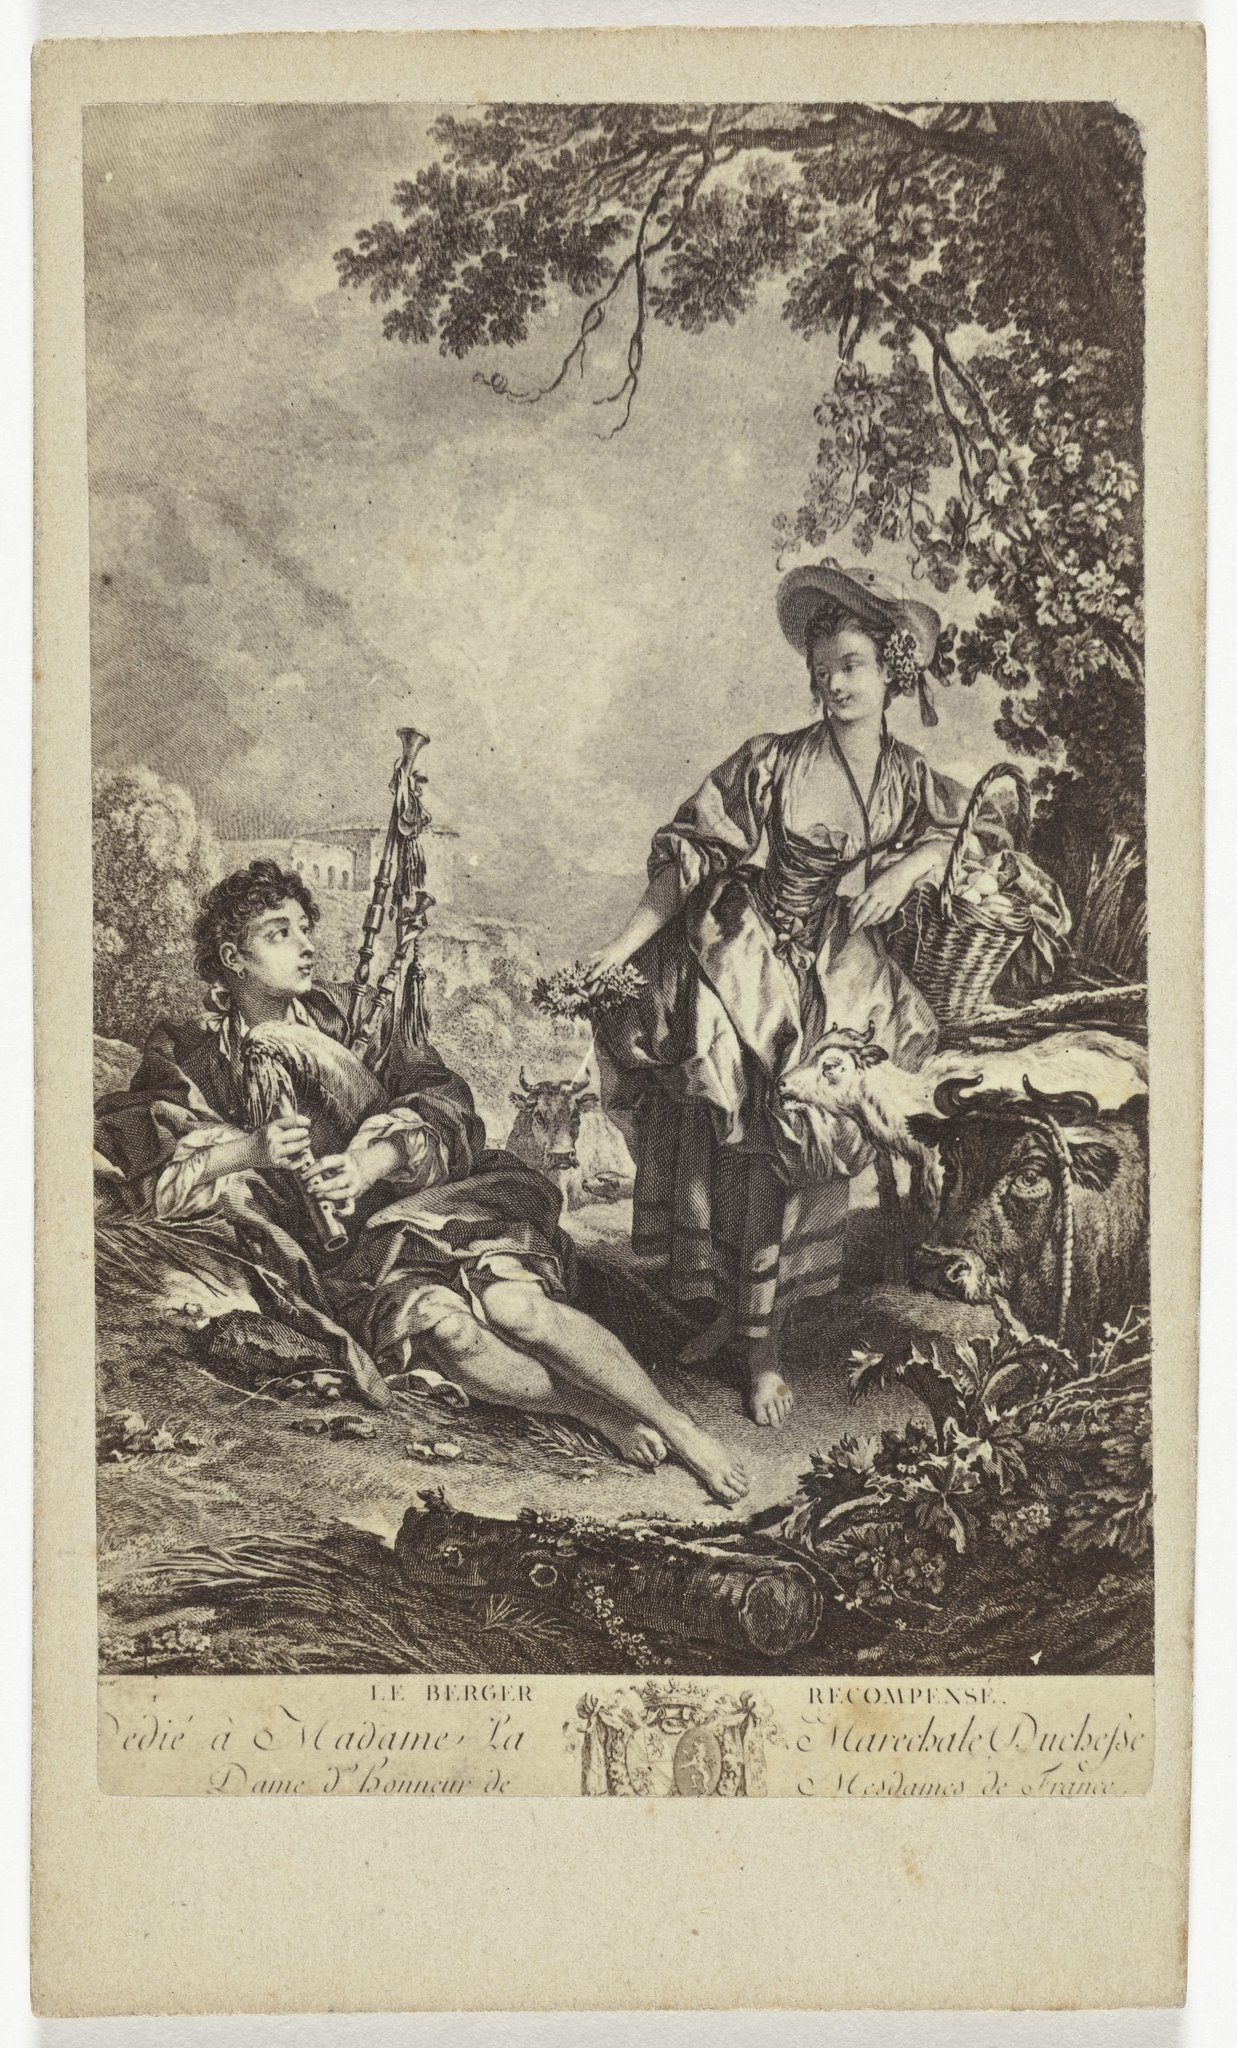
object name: reproduction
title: Fotoreproductie van een gravure naar een schilderij van rustende herders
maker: Anonymous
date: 1850-1900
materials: cardboard, photographic support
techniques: albumen print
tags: herding, herdsman, herdswoman, shepherd, shepherdess, cowherd, etc.